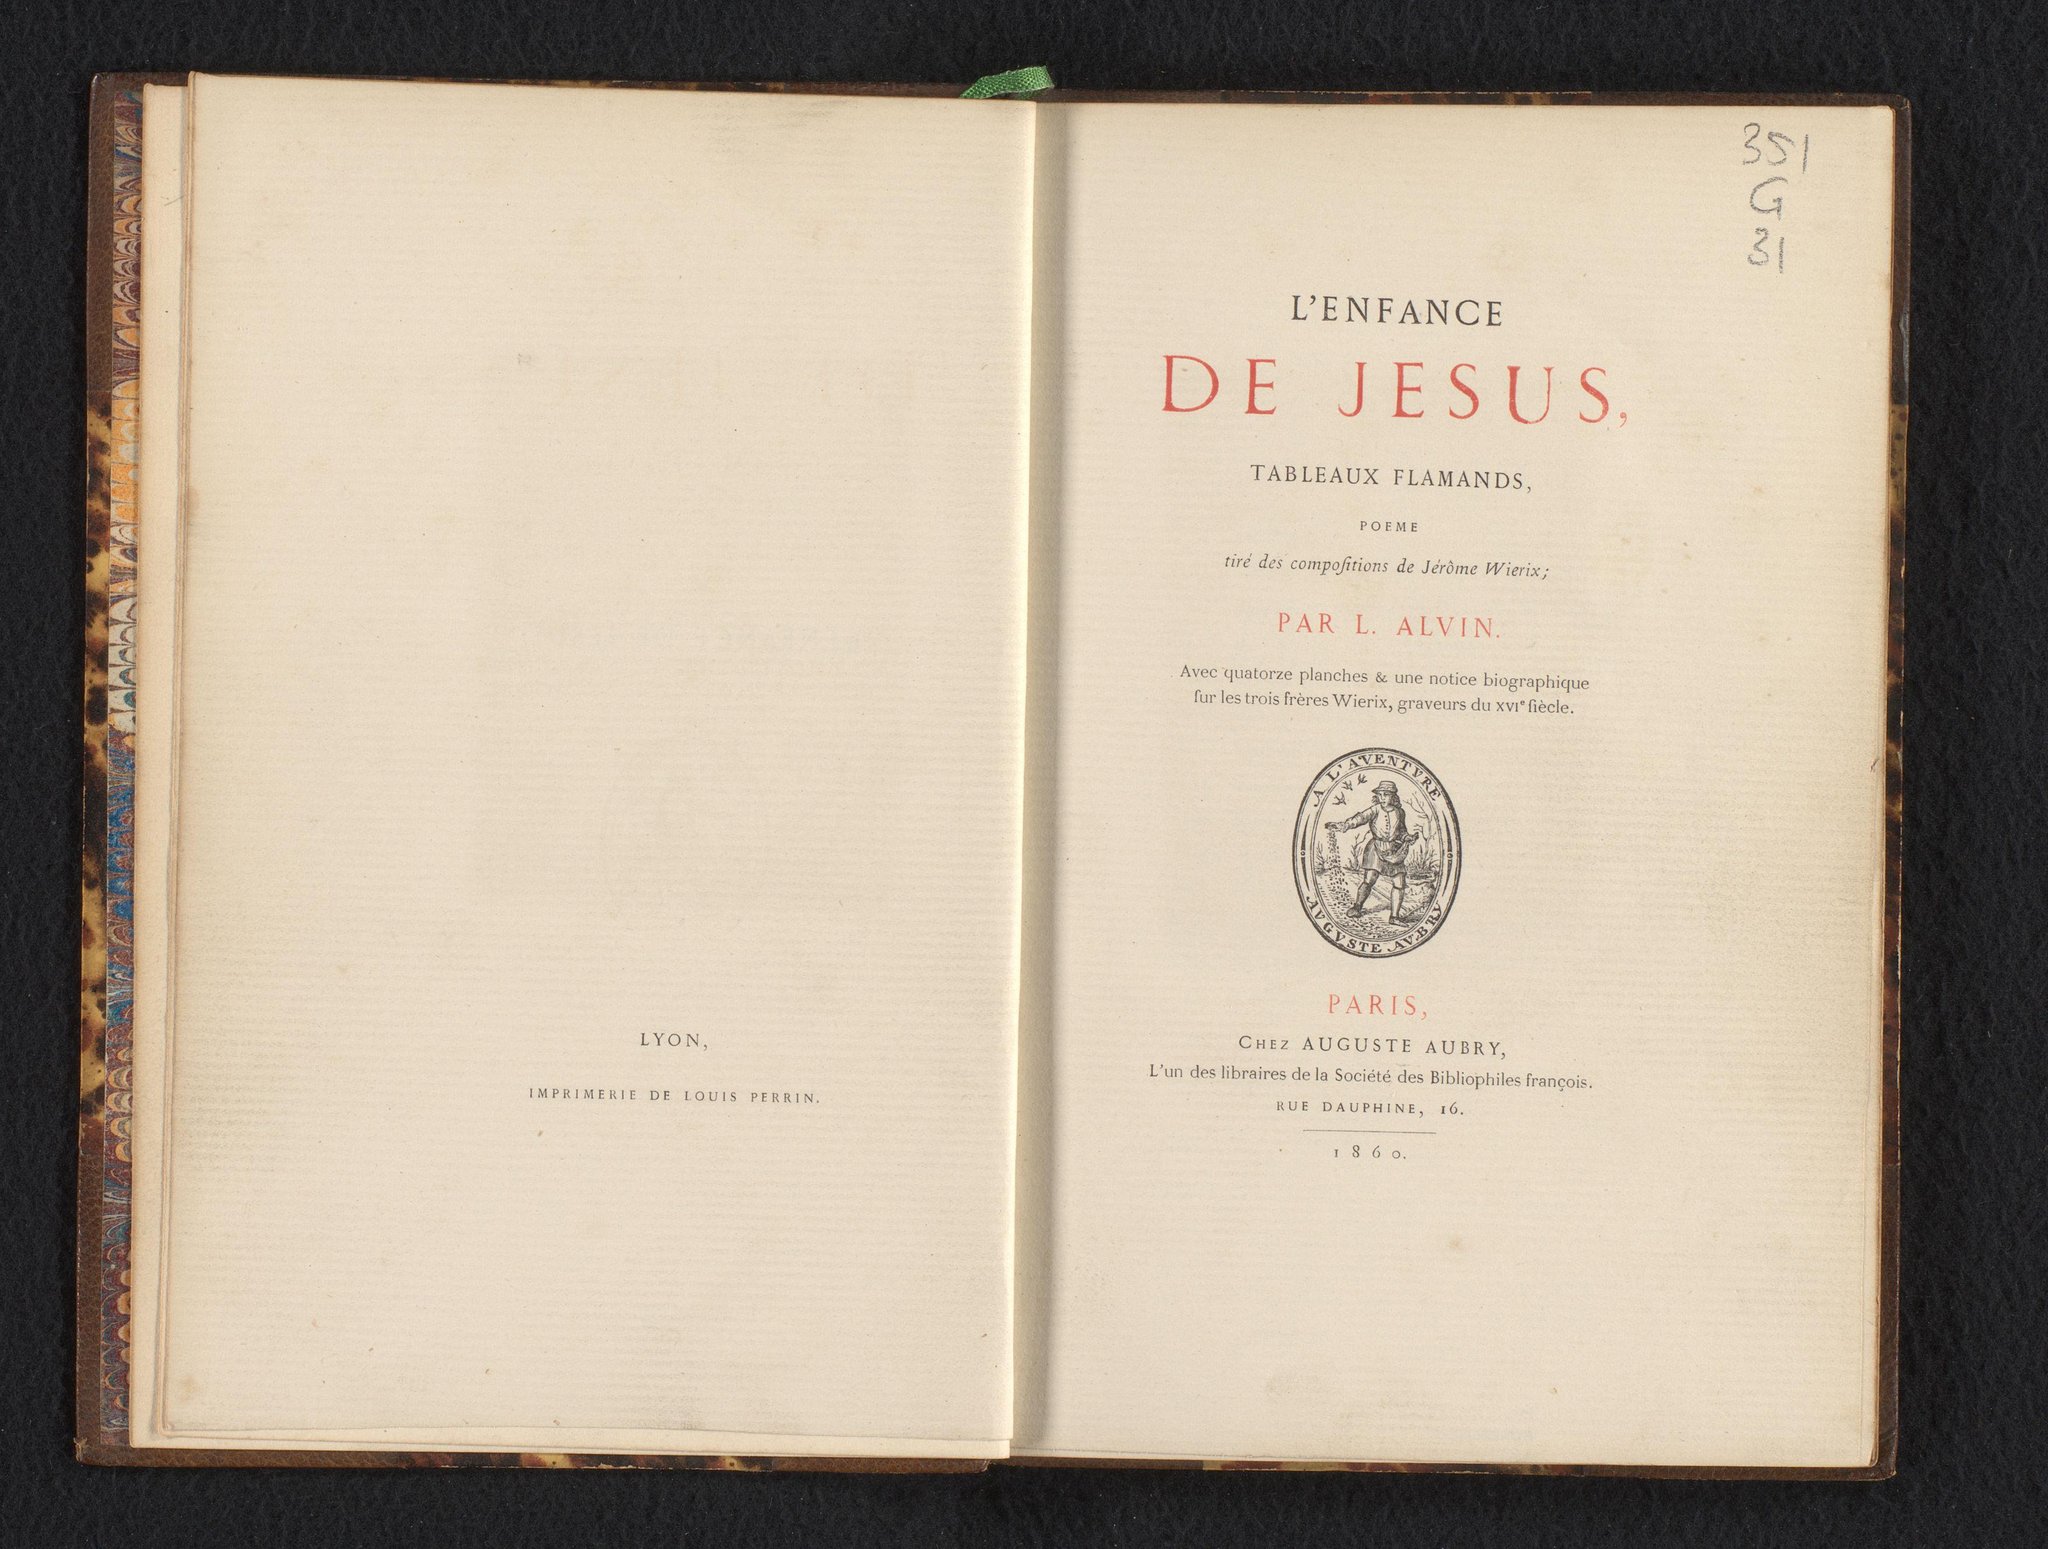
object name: book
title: L'enfance de Jésus : tableaux flamands : poème tiré des compositions de Jérôme Wierix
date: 1860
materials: cardboard, leather, paper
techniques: albumen print, marbled paper, letterpress printing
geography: paris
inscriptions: inscription: ‘JDoedes/ [?]’, bookplate: ‘SUBLIMIA CURO’, inscription: ‘30-/ ex libris/ Doedes’